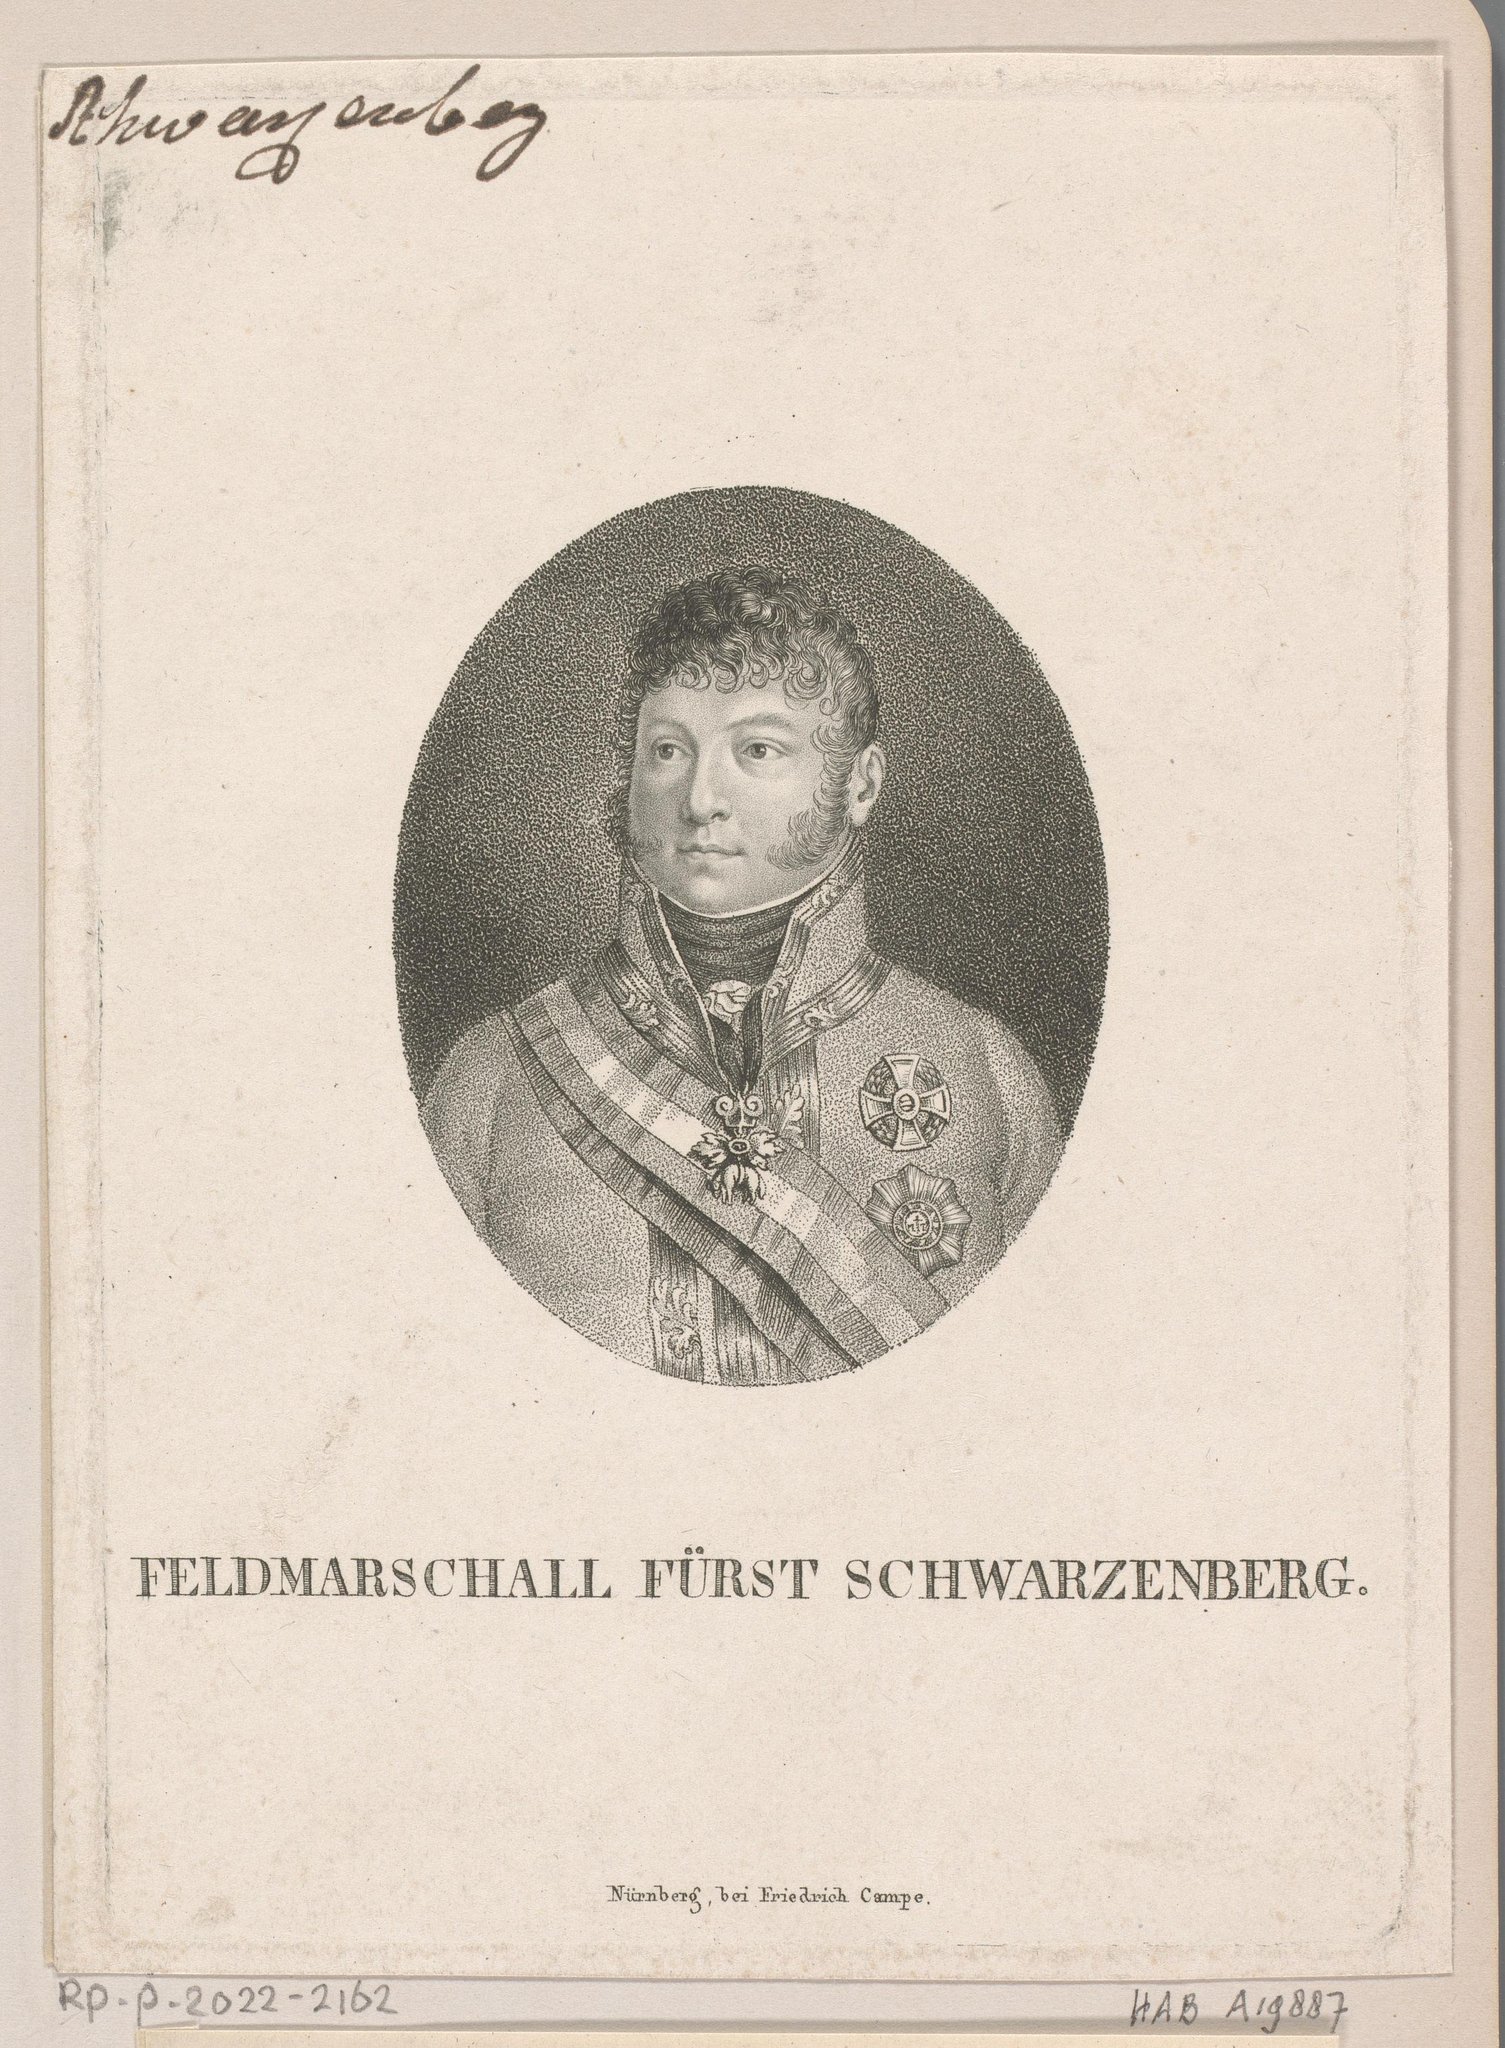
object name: print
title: Portret van Carl Philipp von Schwarzenberg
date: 1812-1834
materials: paper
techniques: etching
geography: nuremberg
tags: vienna, commander-in-chief, general, marshal, historical persons, knighthood order of the golden fleece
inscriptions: name: ‘Schwarzenberg’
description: Met eenregelig onderschrift in het Duits.